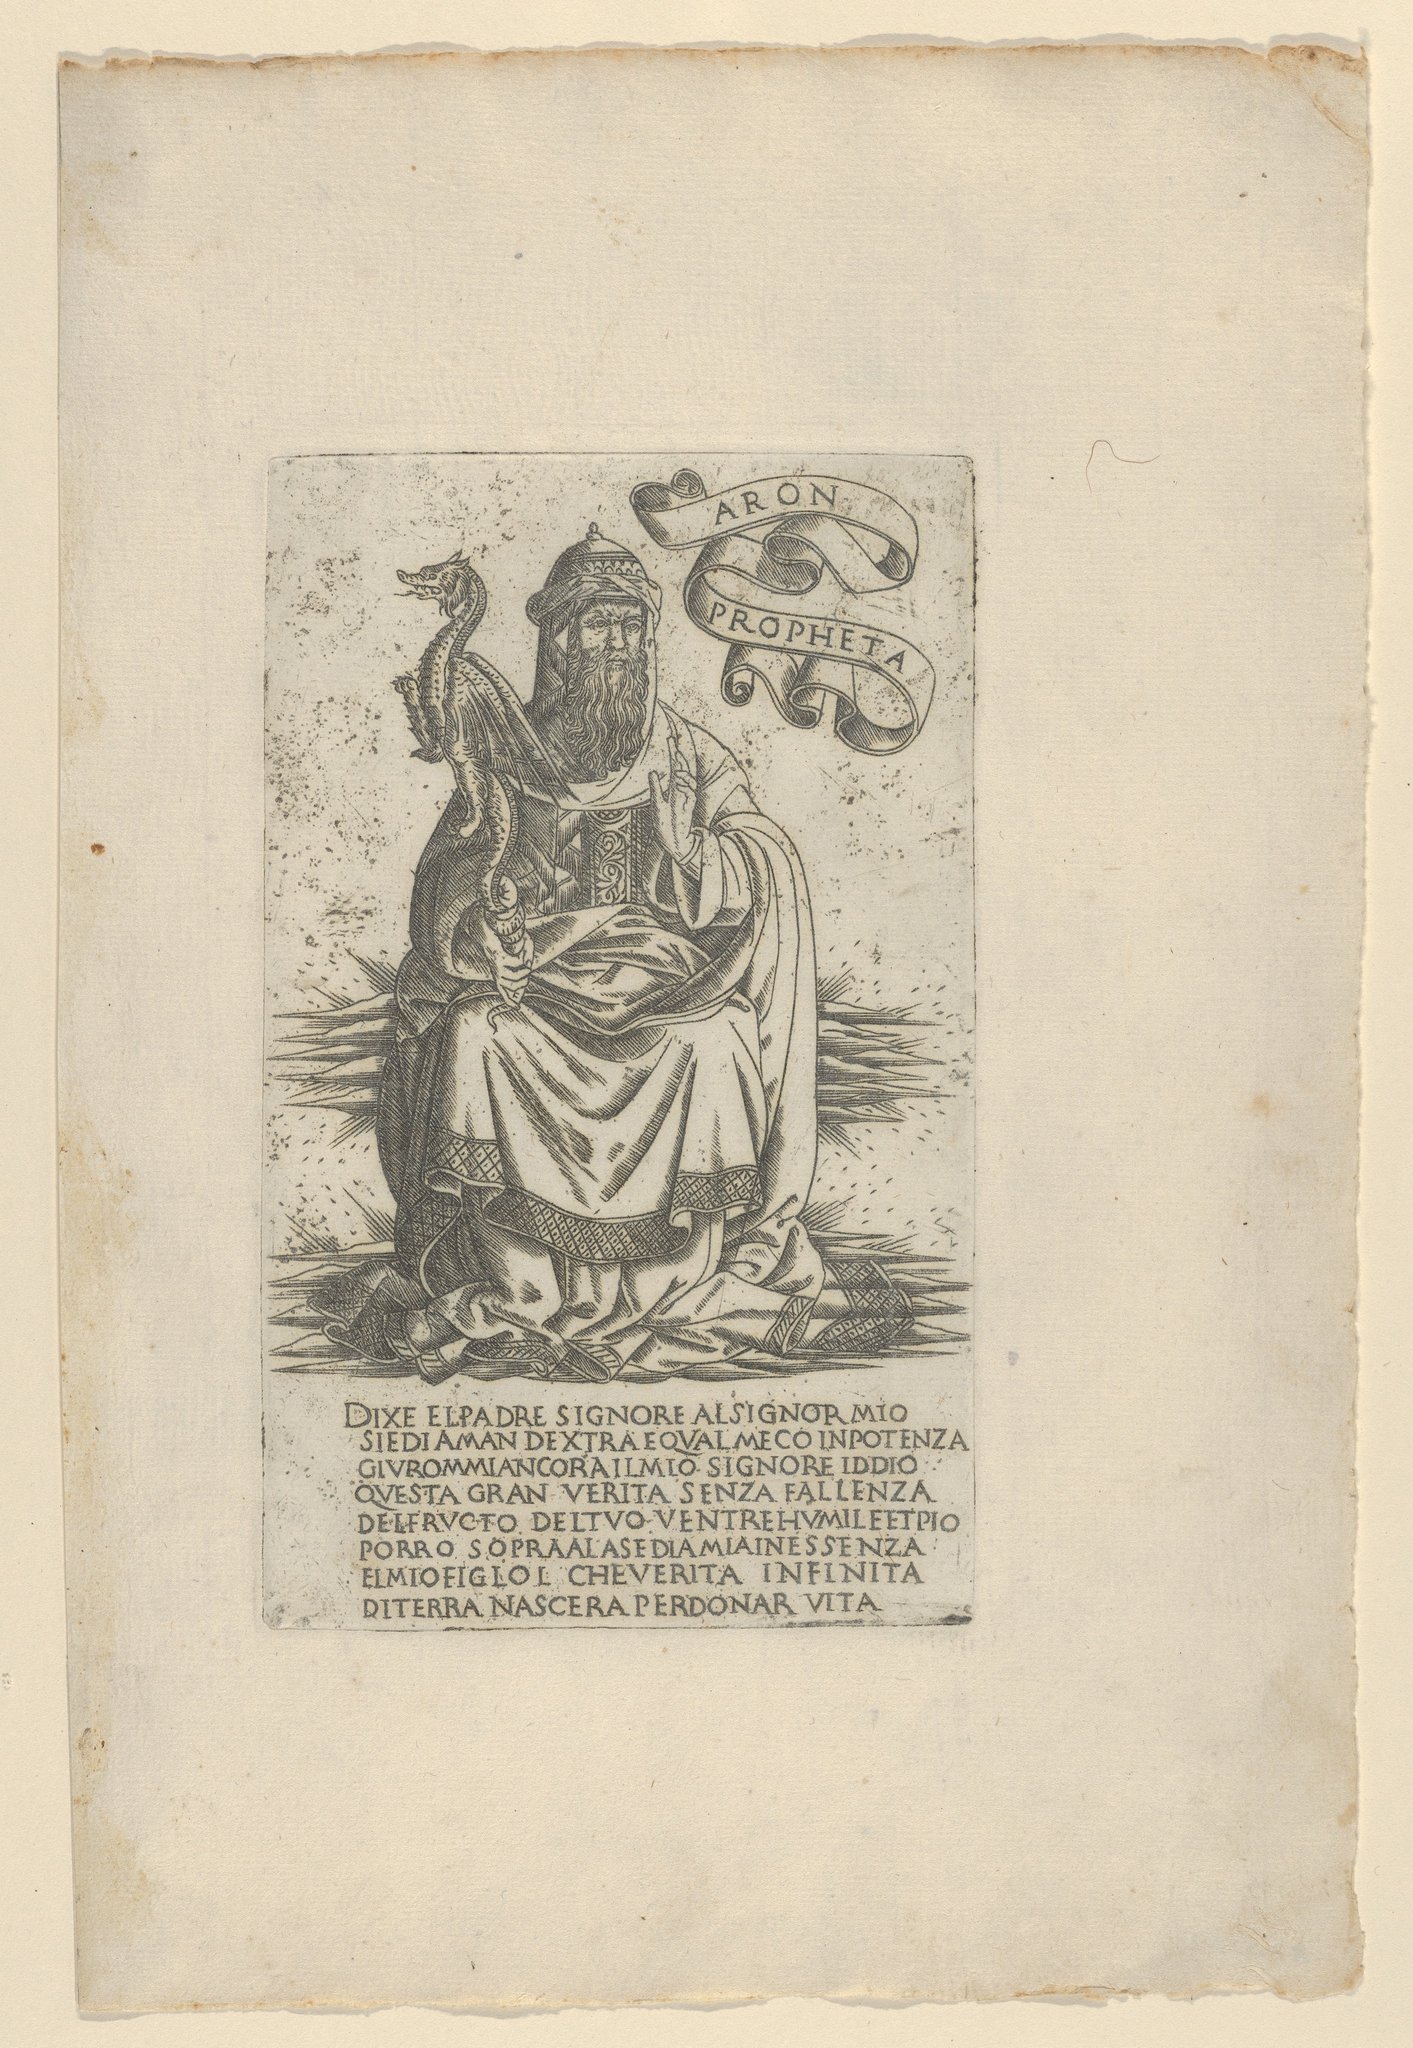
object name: print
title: The Prophet Aaron, from Prophets and Sibyls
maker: francesco rosselli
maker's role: artist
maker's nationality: italian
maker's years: 1448-1527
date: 1480-1490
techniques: engraving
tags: men